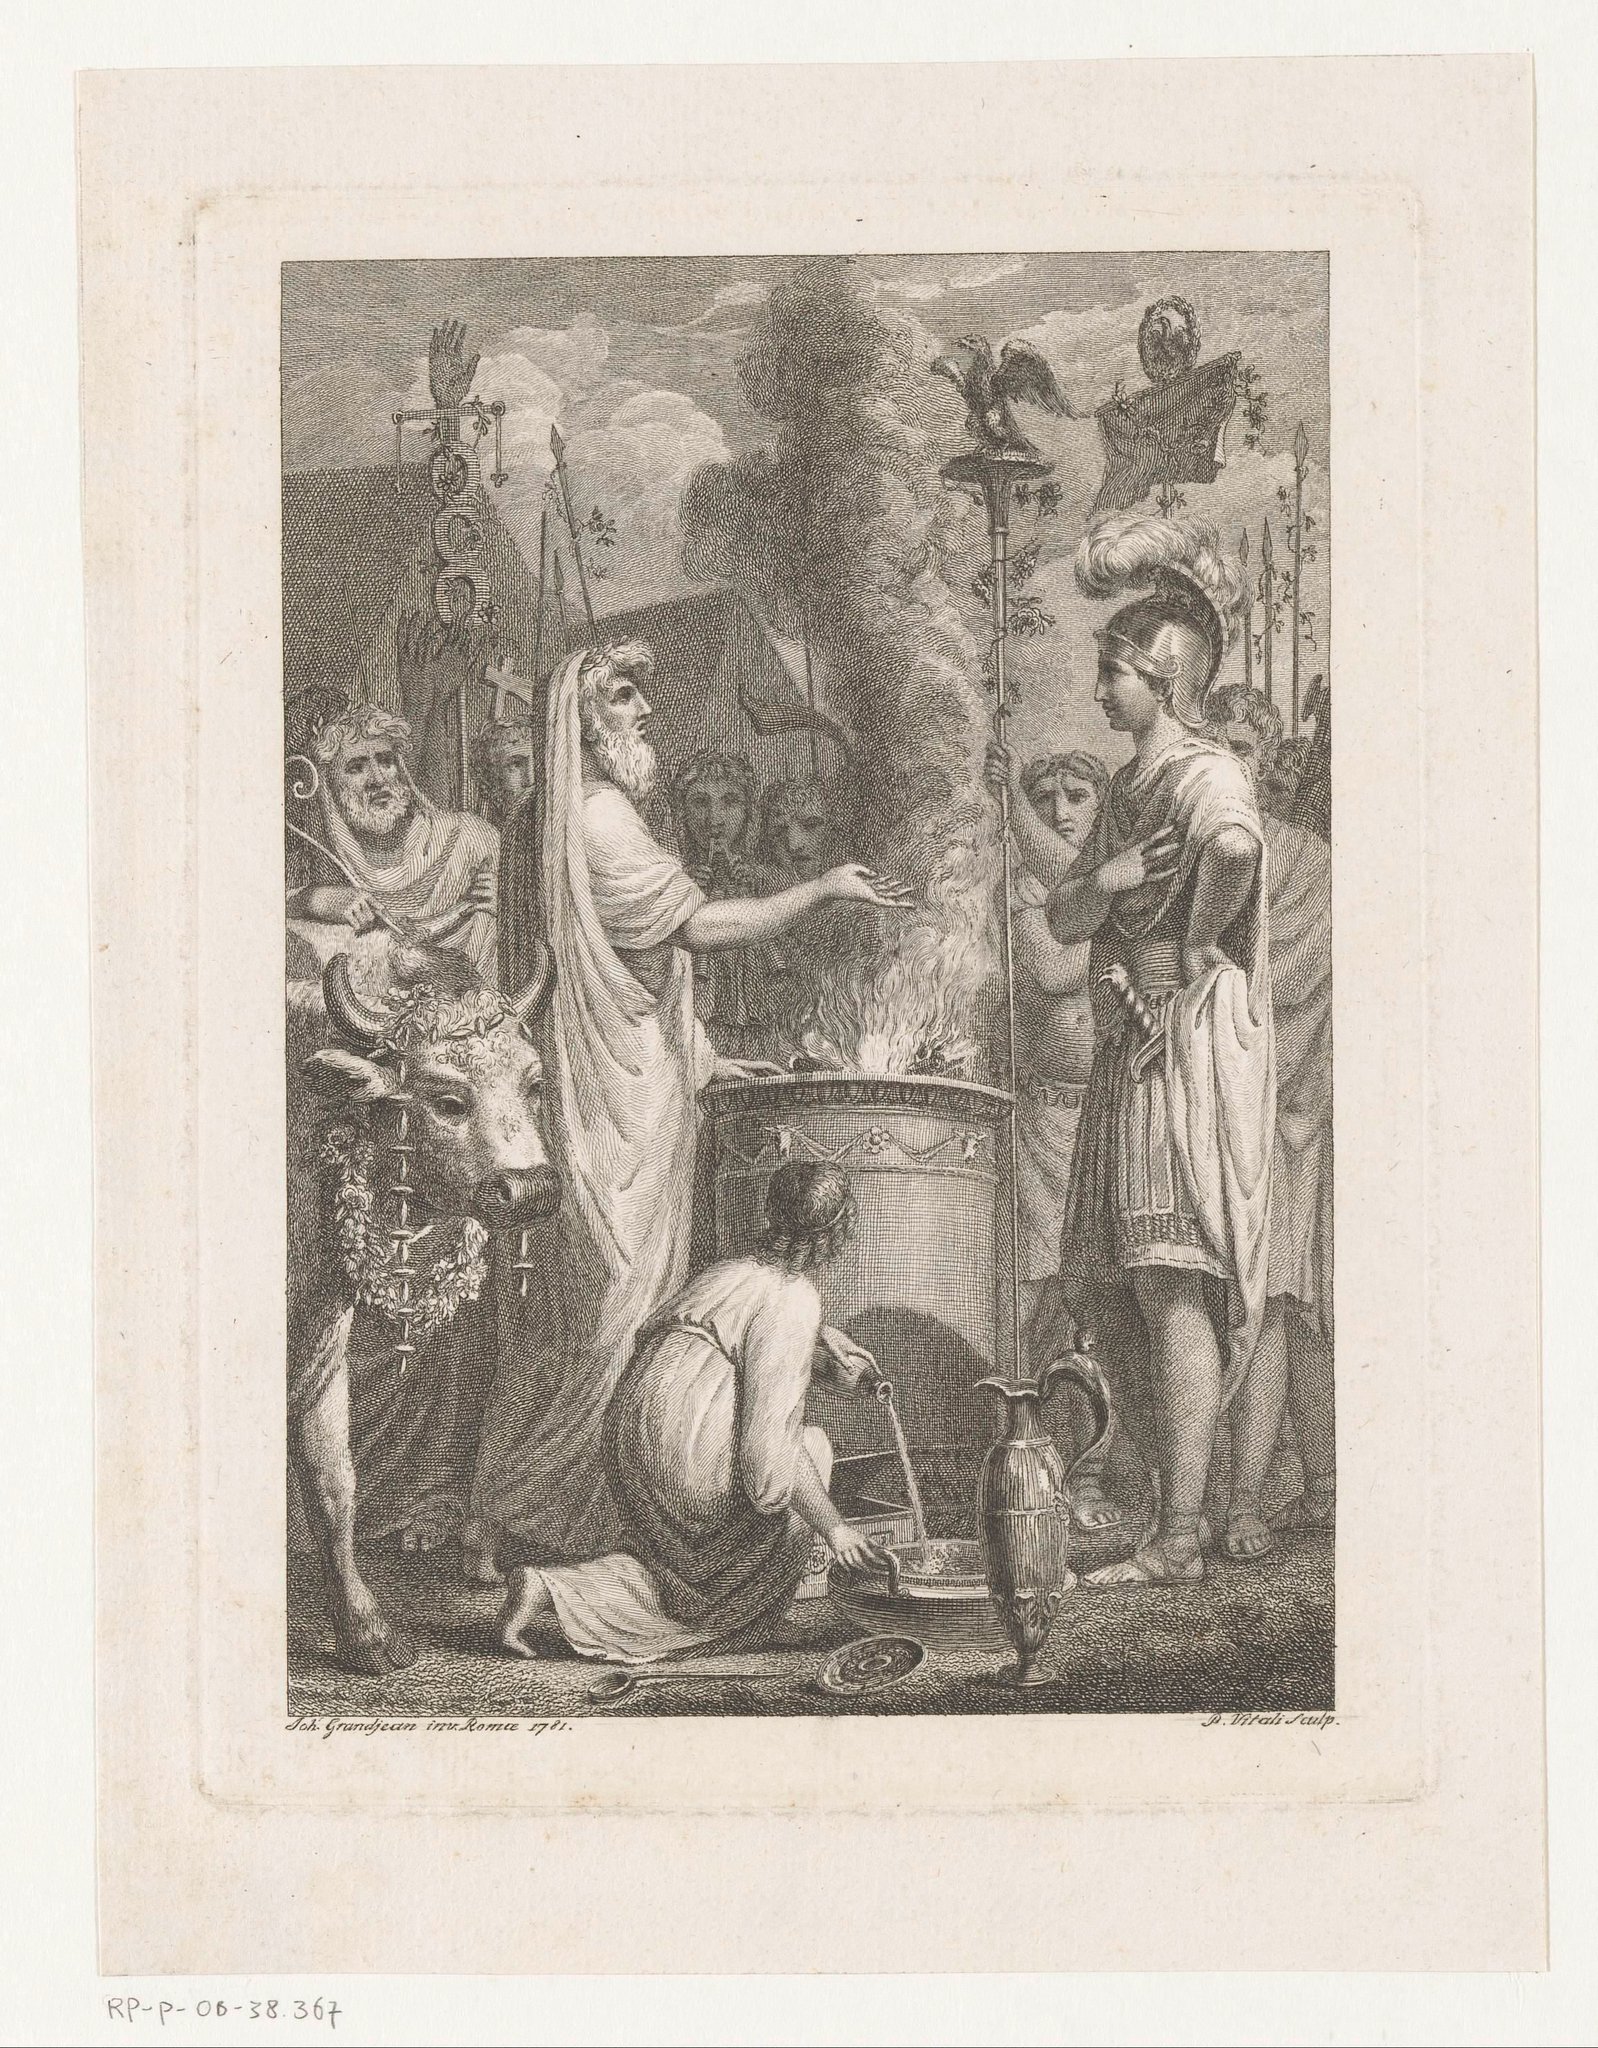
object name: print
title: Germanicus bij een offer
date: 1781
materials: paper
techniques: engraving, etching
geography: italy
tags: (story of) germanicus, sacrifice ~ roman religion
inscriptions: collector's mark: Lugt 2228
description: Prent gebruikt voor de publicatie: Winter, Lucretia Wilhelmina van. Germanicus: In zestien boeken. Amsterdam: P. Meijer, 1779.